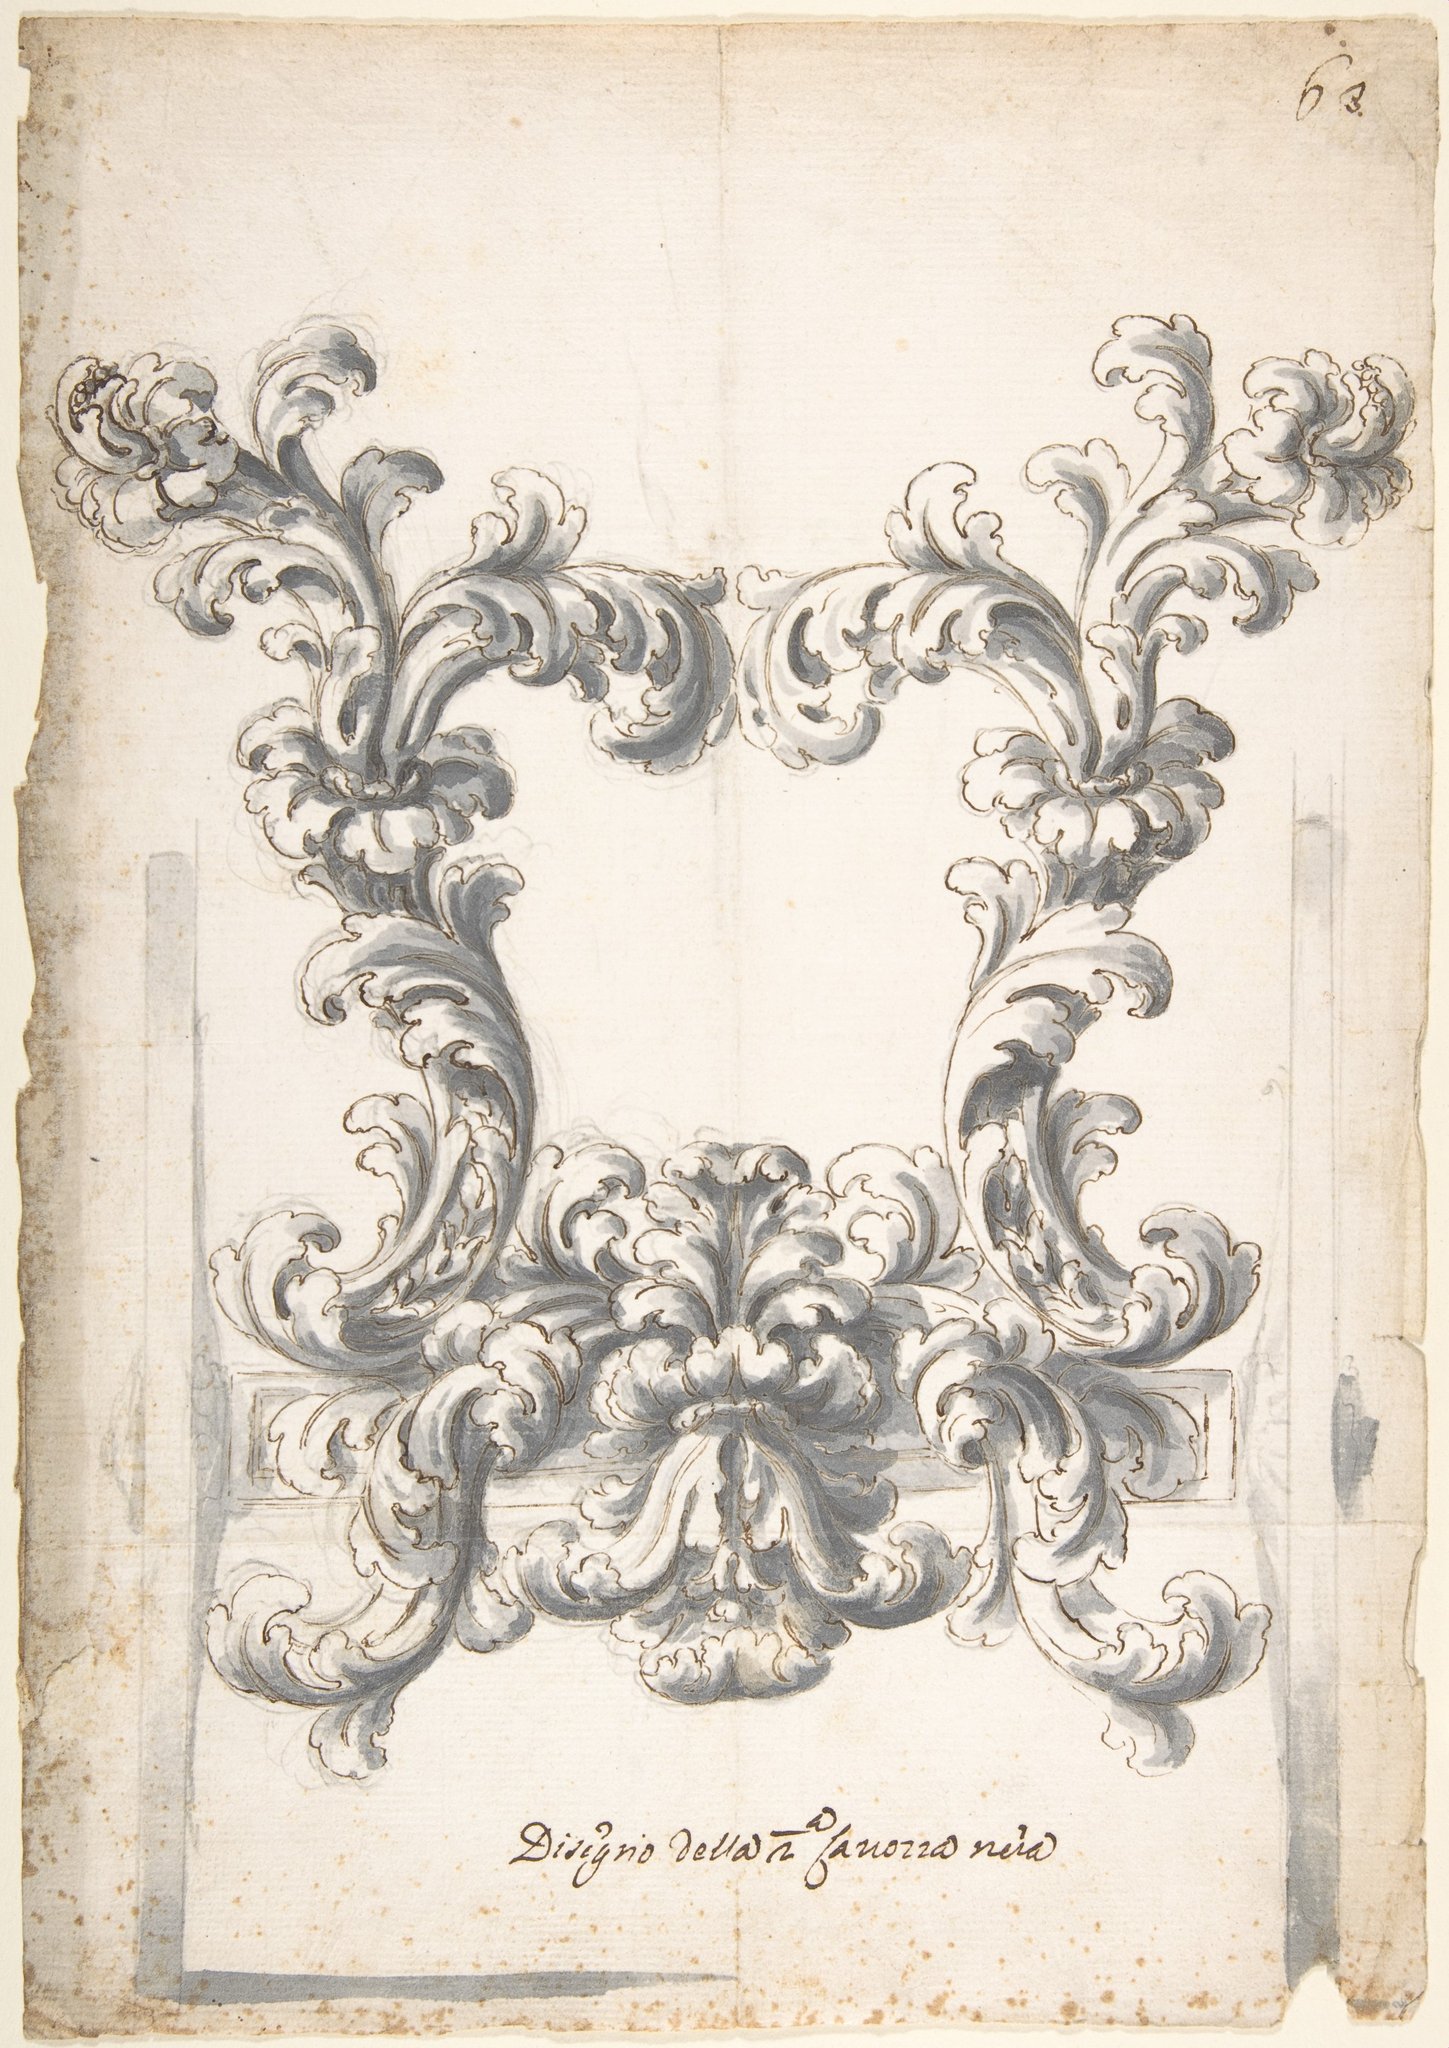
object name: drawing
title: Carriage Design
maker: anonymous, italian, 17th or 18th century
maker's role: artist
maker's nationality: italian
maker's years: 1600-1799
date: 1601-1800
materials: ink, drawing material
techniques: brush, pen, wash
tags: carriages